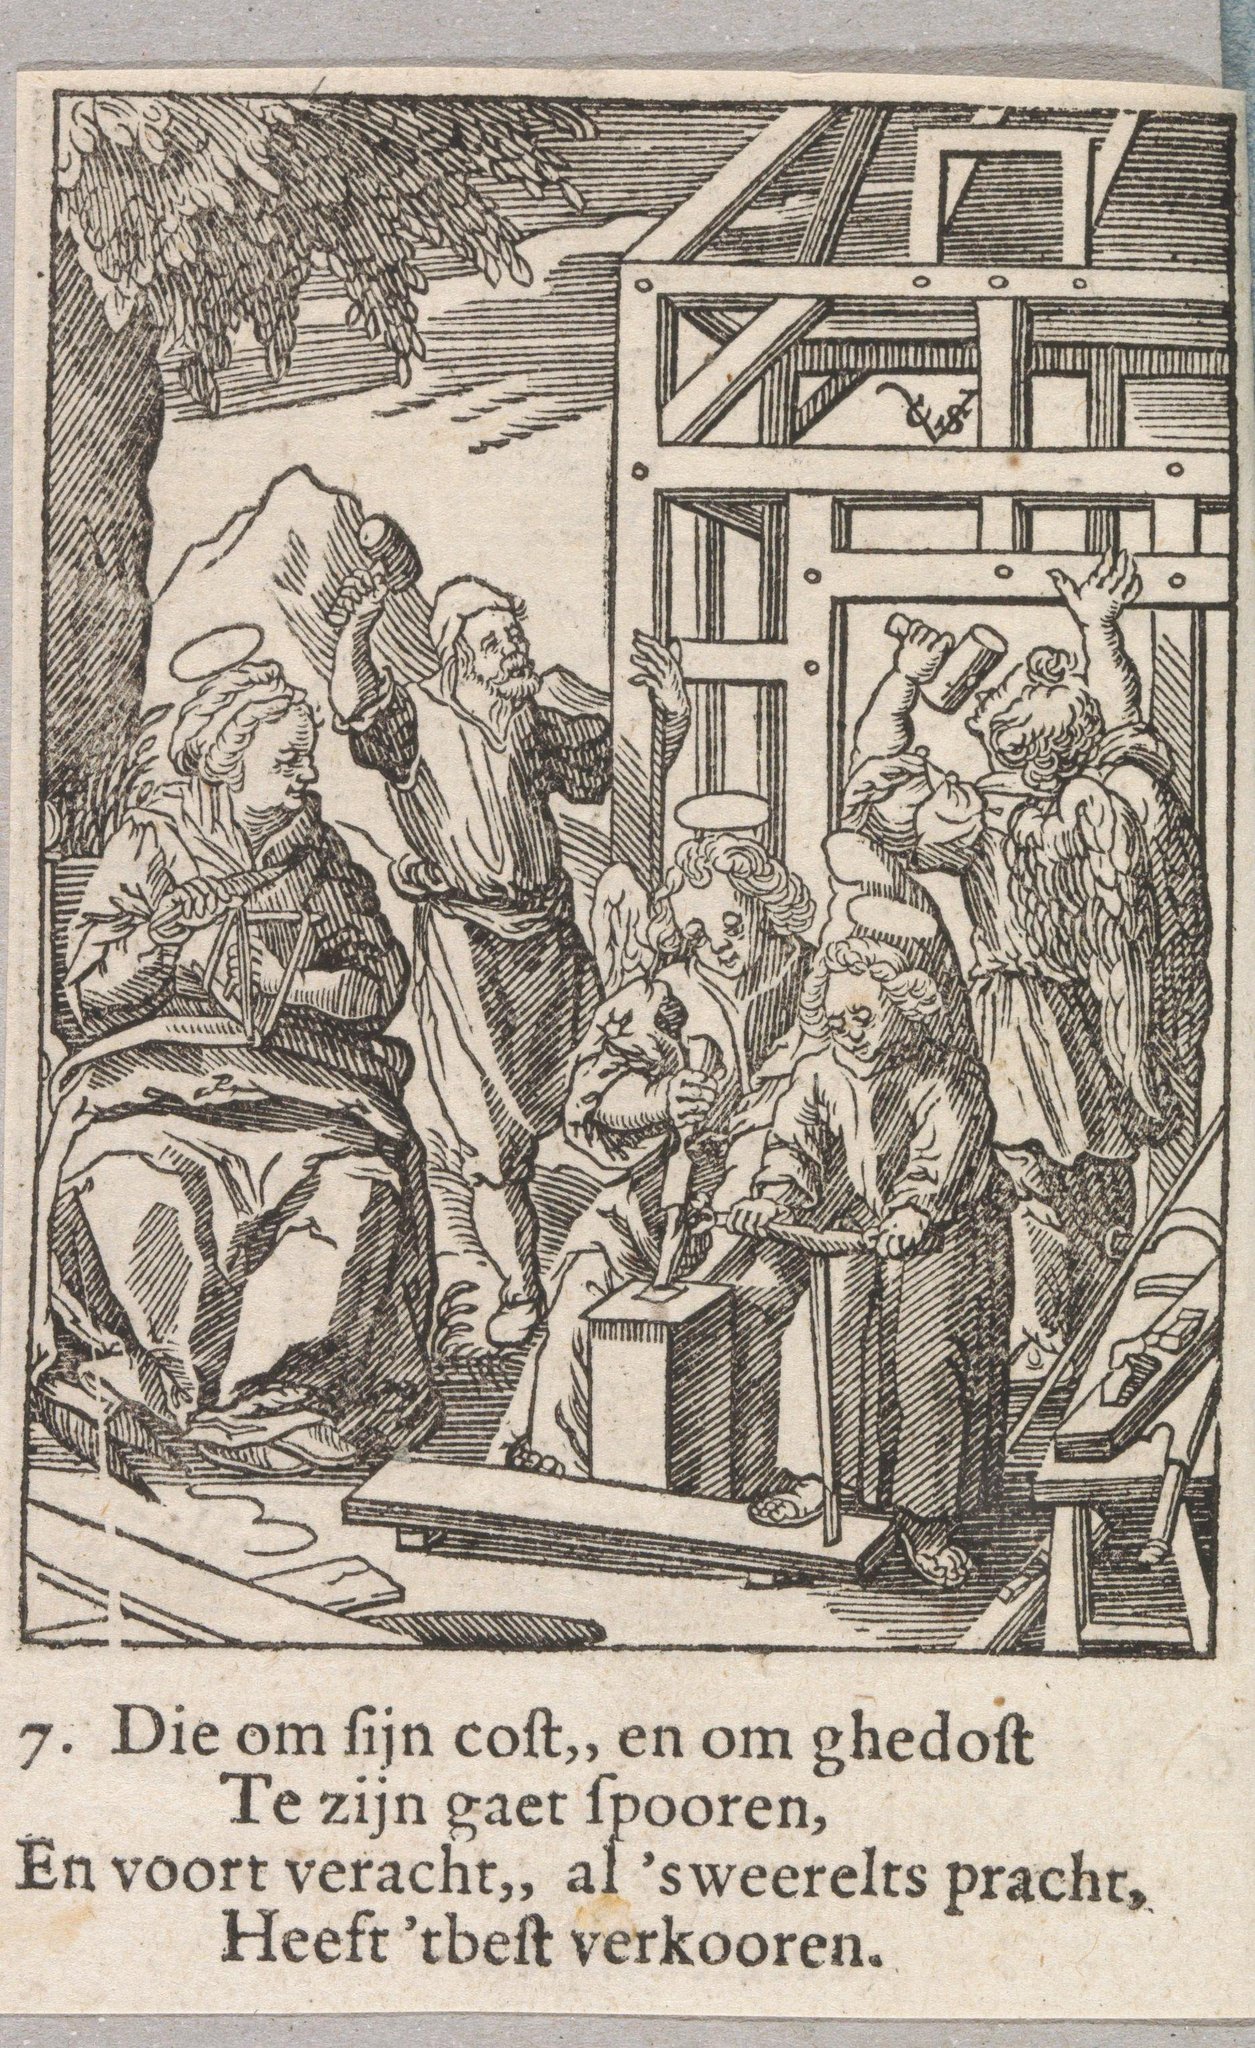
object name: book illustration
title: Christuskind bouwt een huis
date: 1617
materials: paper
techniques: letterpress printing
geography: amsterdam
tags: joseph and the christ-child ~ daily life in nazareth, angels, household occupations of mary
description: De prent verscheen in 1617 bij J.P. Paets als onderdeel van de serie over de jeugd van Christus. Daarnaast werd de houtsnede gebruikt in: Der Zielen Lust-hof. Leuven, I.Jacbosz voor P.J. Paets [= Amsterdam, P.J. Paets], 1629; Bibels Tresoor ofte der zielen lusthof. Amsterdam, P.J. Paets, 1646 en tSchat der Zielen. Amsterdam, P.J. Paets, 1648.